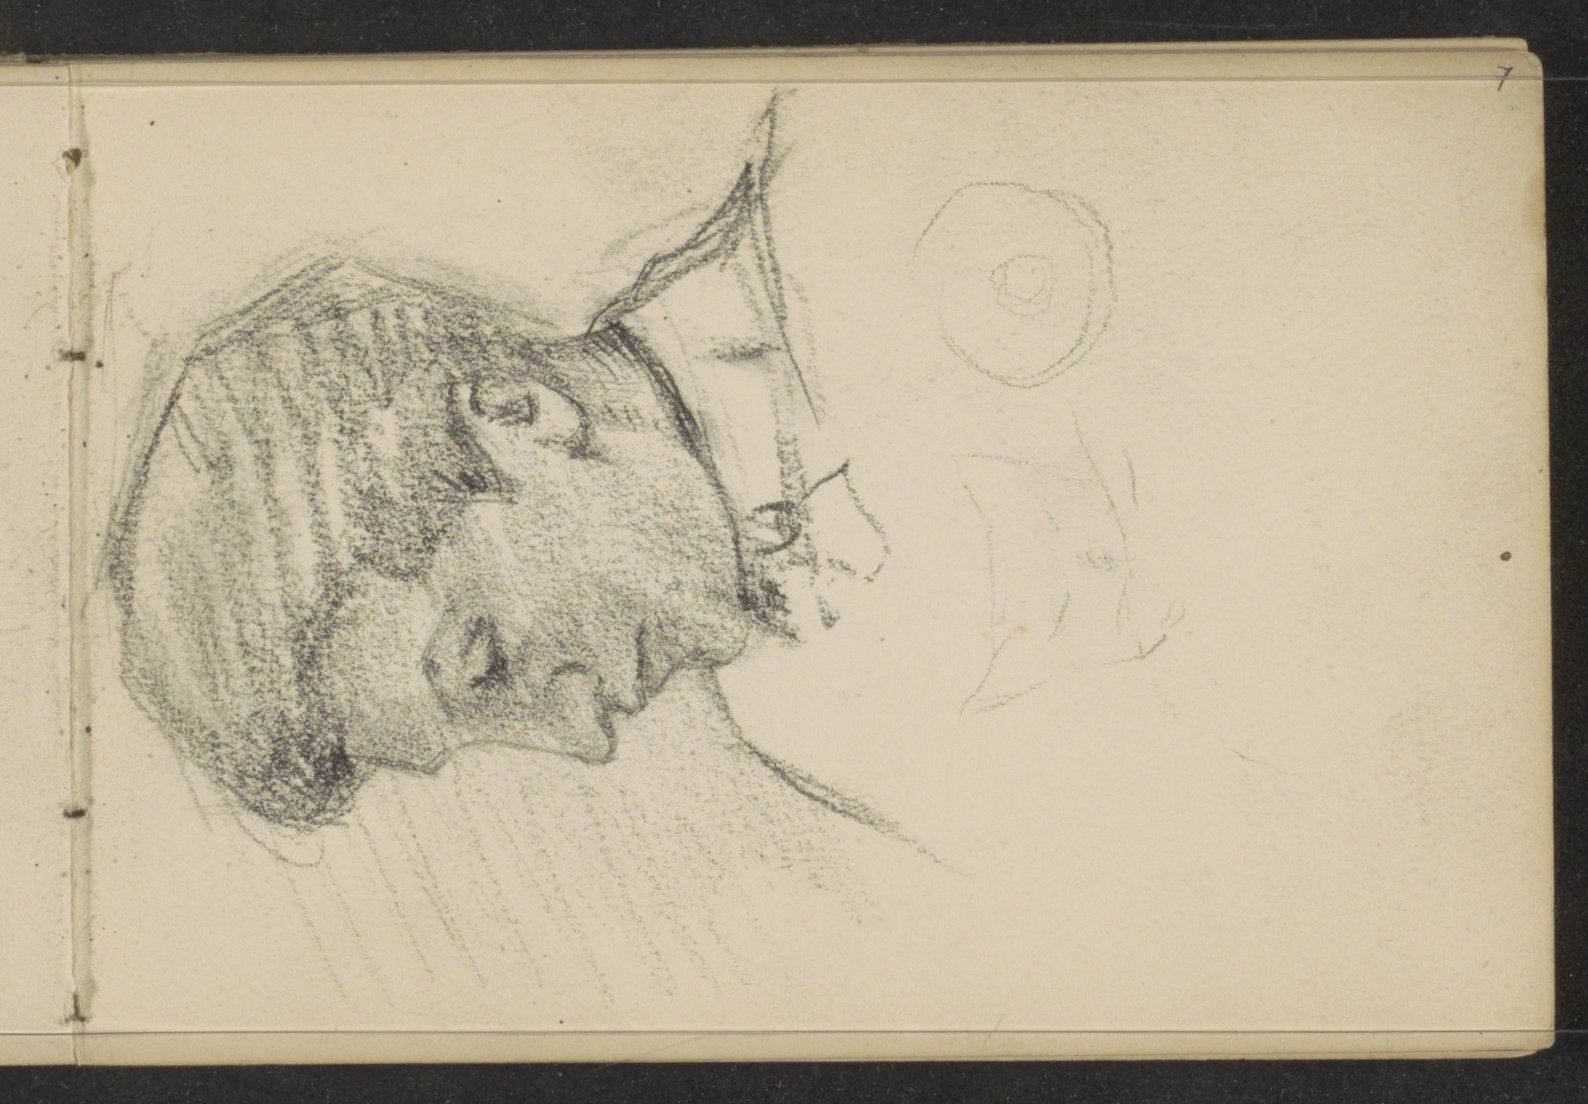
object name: sketchbook leaf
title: Portret van een vrouw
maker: Anonymous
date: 1880-1900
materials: paper, pencil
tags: cat, anonymous historical person portrayed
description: Tevens een studie van de kop van een kat. Blad 7 recto uit een schetsboek met 29 bladen.